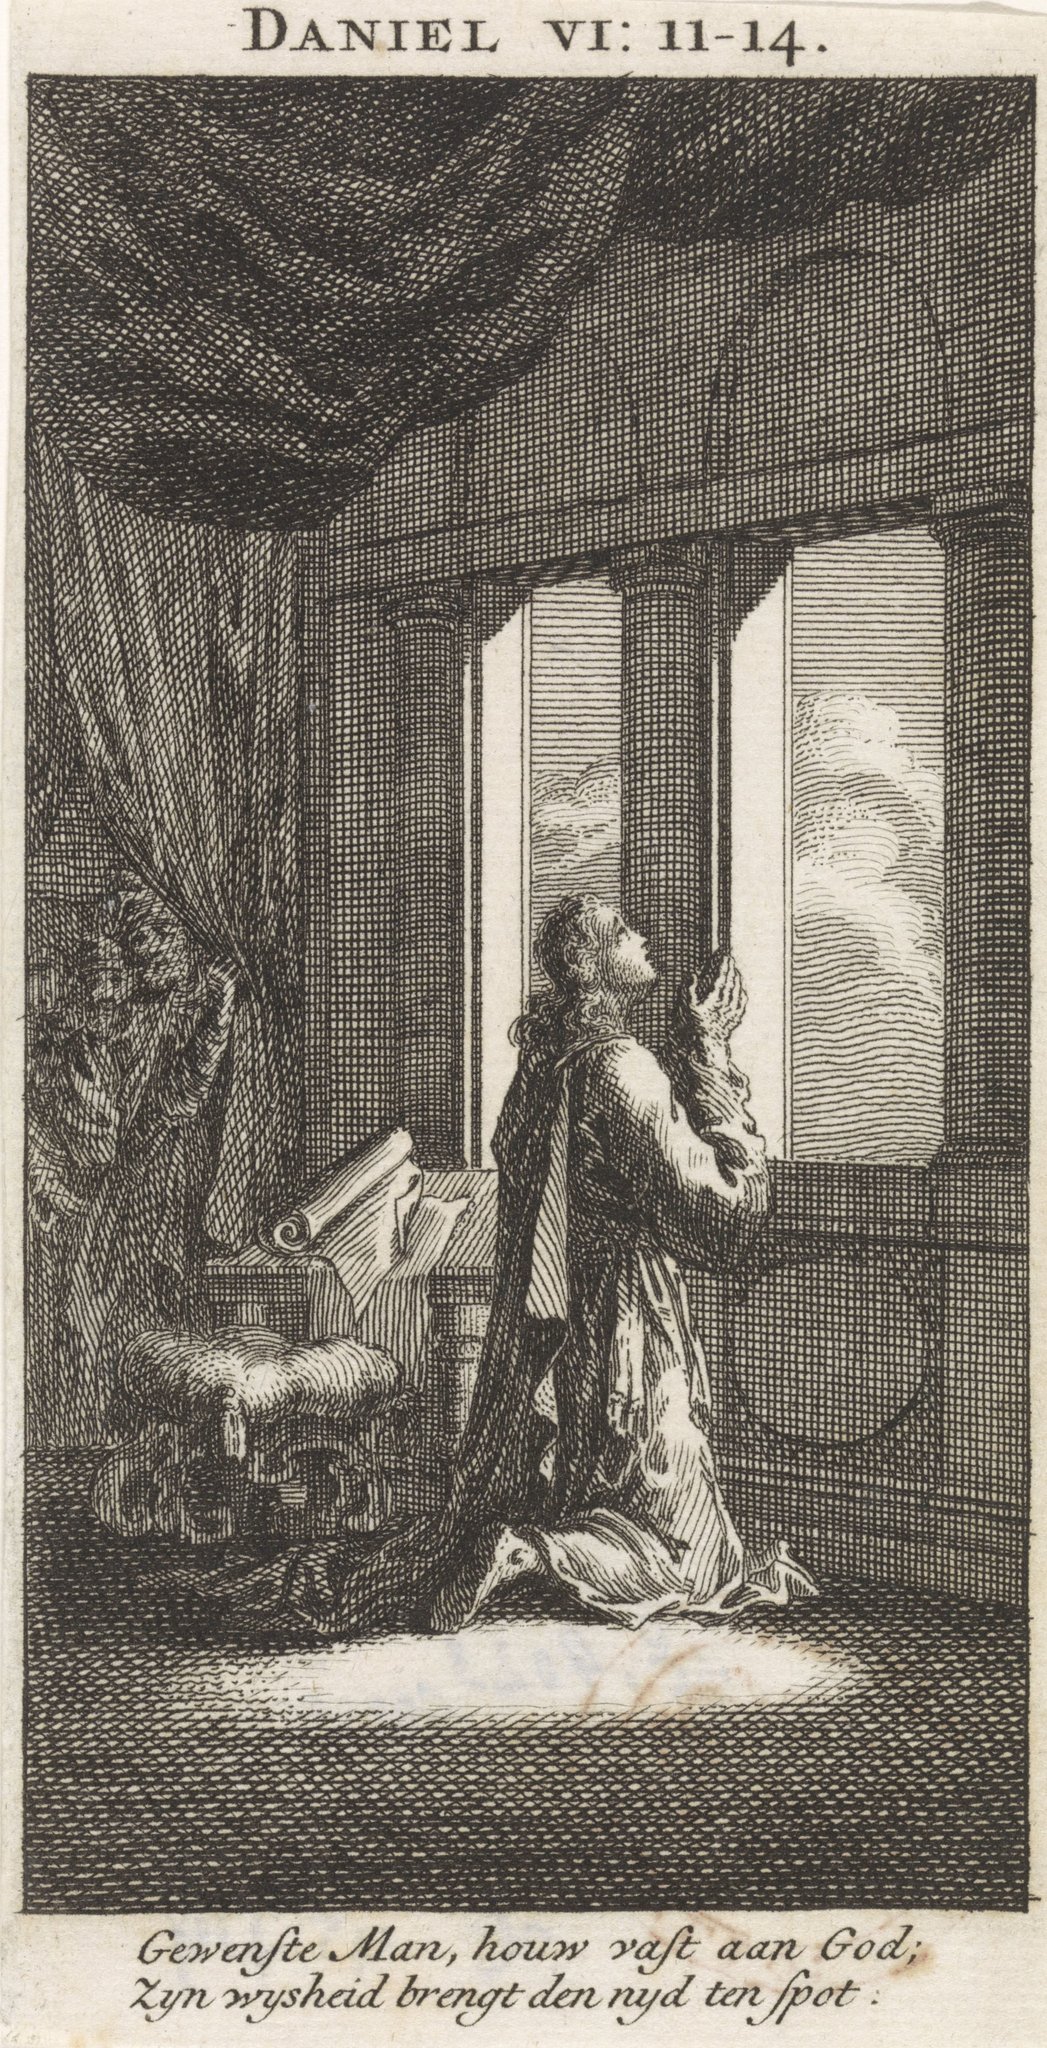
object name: print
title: Daniël geknield voor een venster wordt bespied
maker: jan luyken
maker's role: draughtsman, print maker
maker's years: 1649-1712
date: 1712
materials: paper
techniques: etching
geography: amsterdam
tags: daniel, while praying on his knees before an open window, is discovered by the conspirators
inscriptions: collector's mark: Lugt 240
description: Variant op illustratie voor: Luyken, Jan. Bybel printen. Amsterdam: Pieter Arentsz. II (wed.) en Cornelis van der Sys, 1712, p. 16.